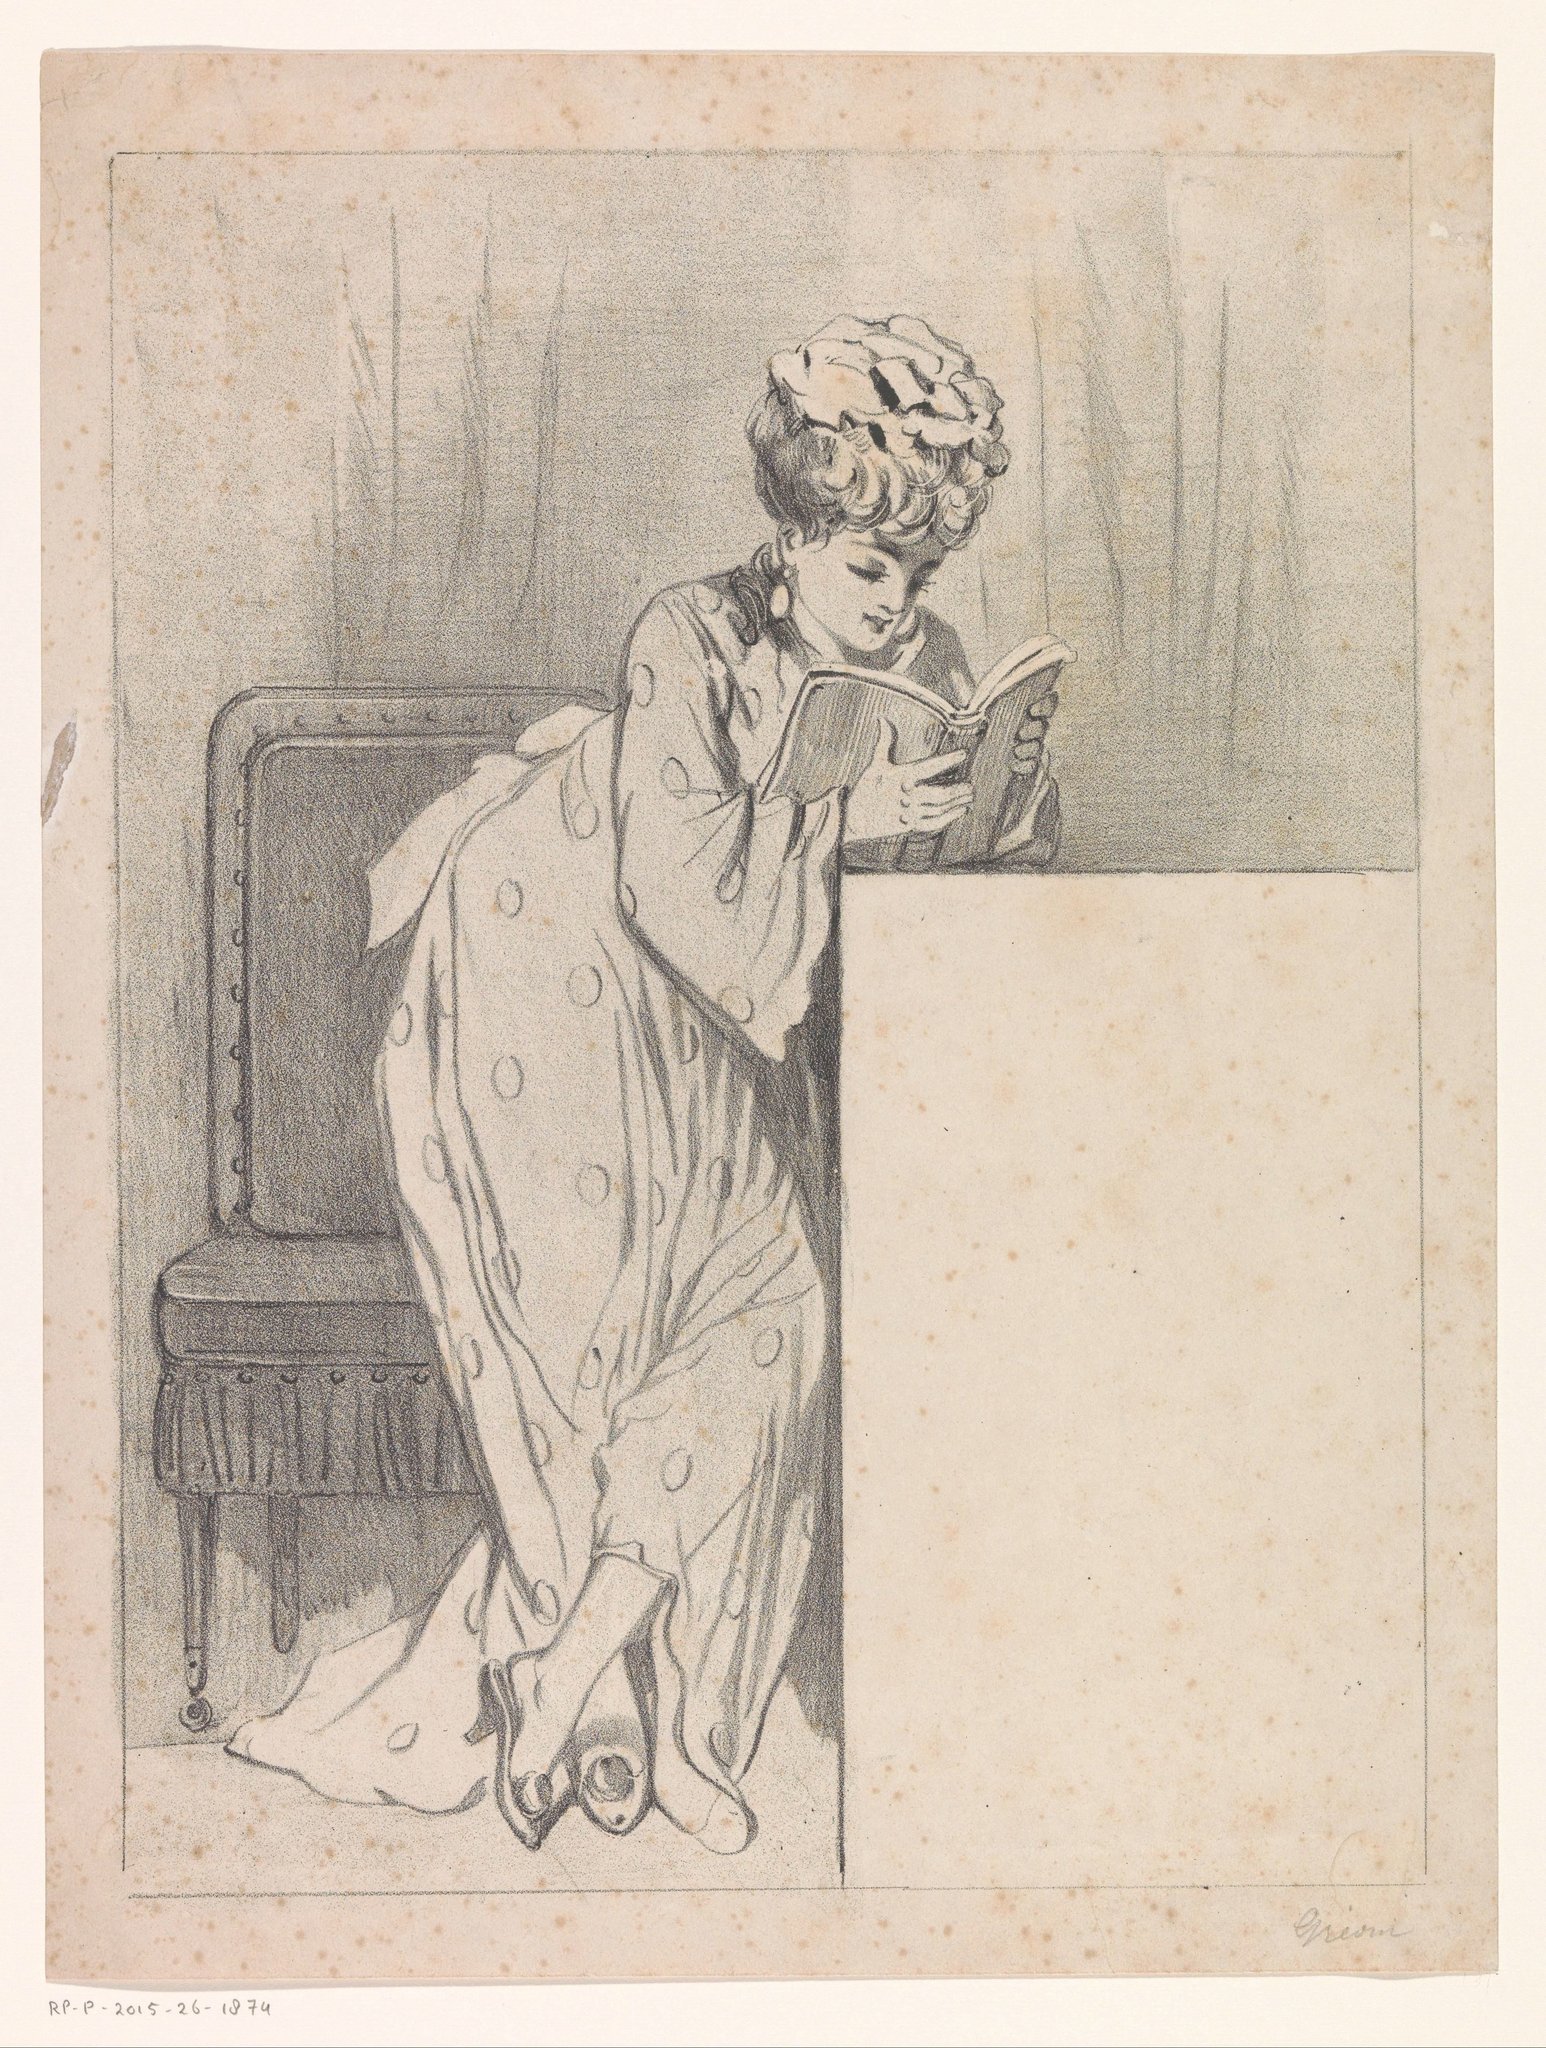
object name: print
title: Lezende vrouw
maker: alfred grévin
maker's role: draughtsman, print maker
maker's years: 1827-1892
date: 1842-1892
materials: paper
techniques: lithograph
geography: paris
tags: reading, book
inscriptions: collector's mark: Lugt 4779, collector's mark: Lugt 2228, inscription: ‘Grevin’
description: Voor een stoel staat een vrouw met een jurk met stippen en een hoed op haar hoofd. In haar handen houdt ze een opengeslagen boek.